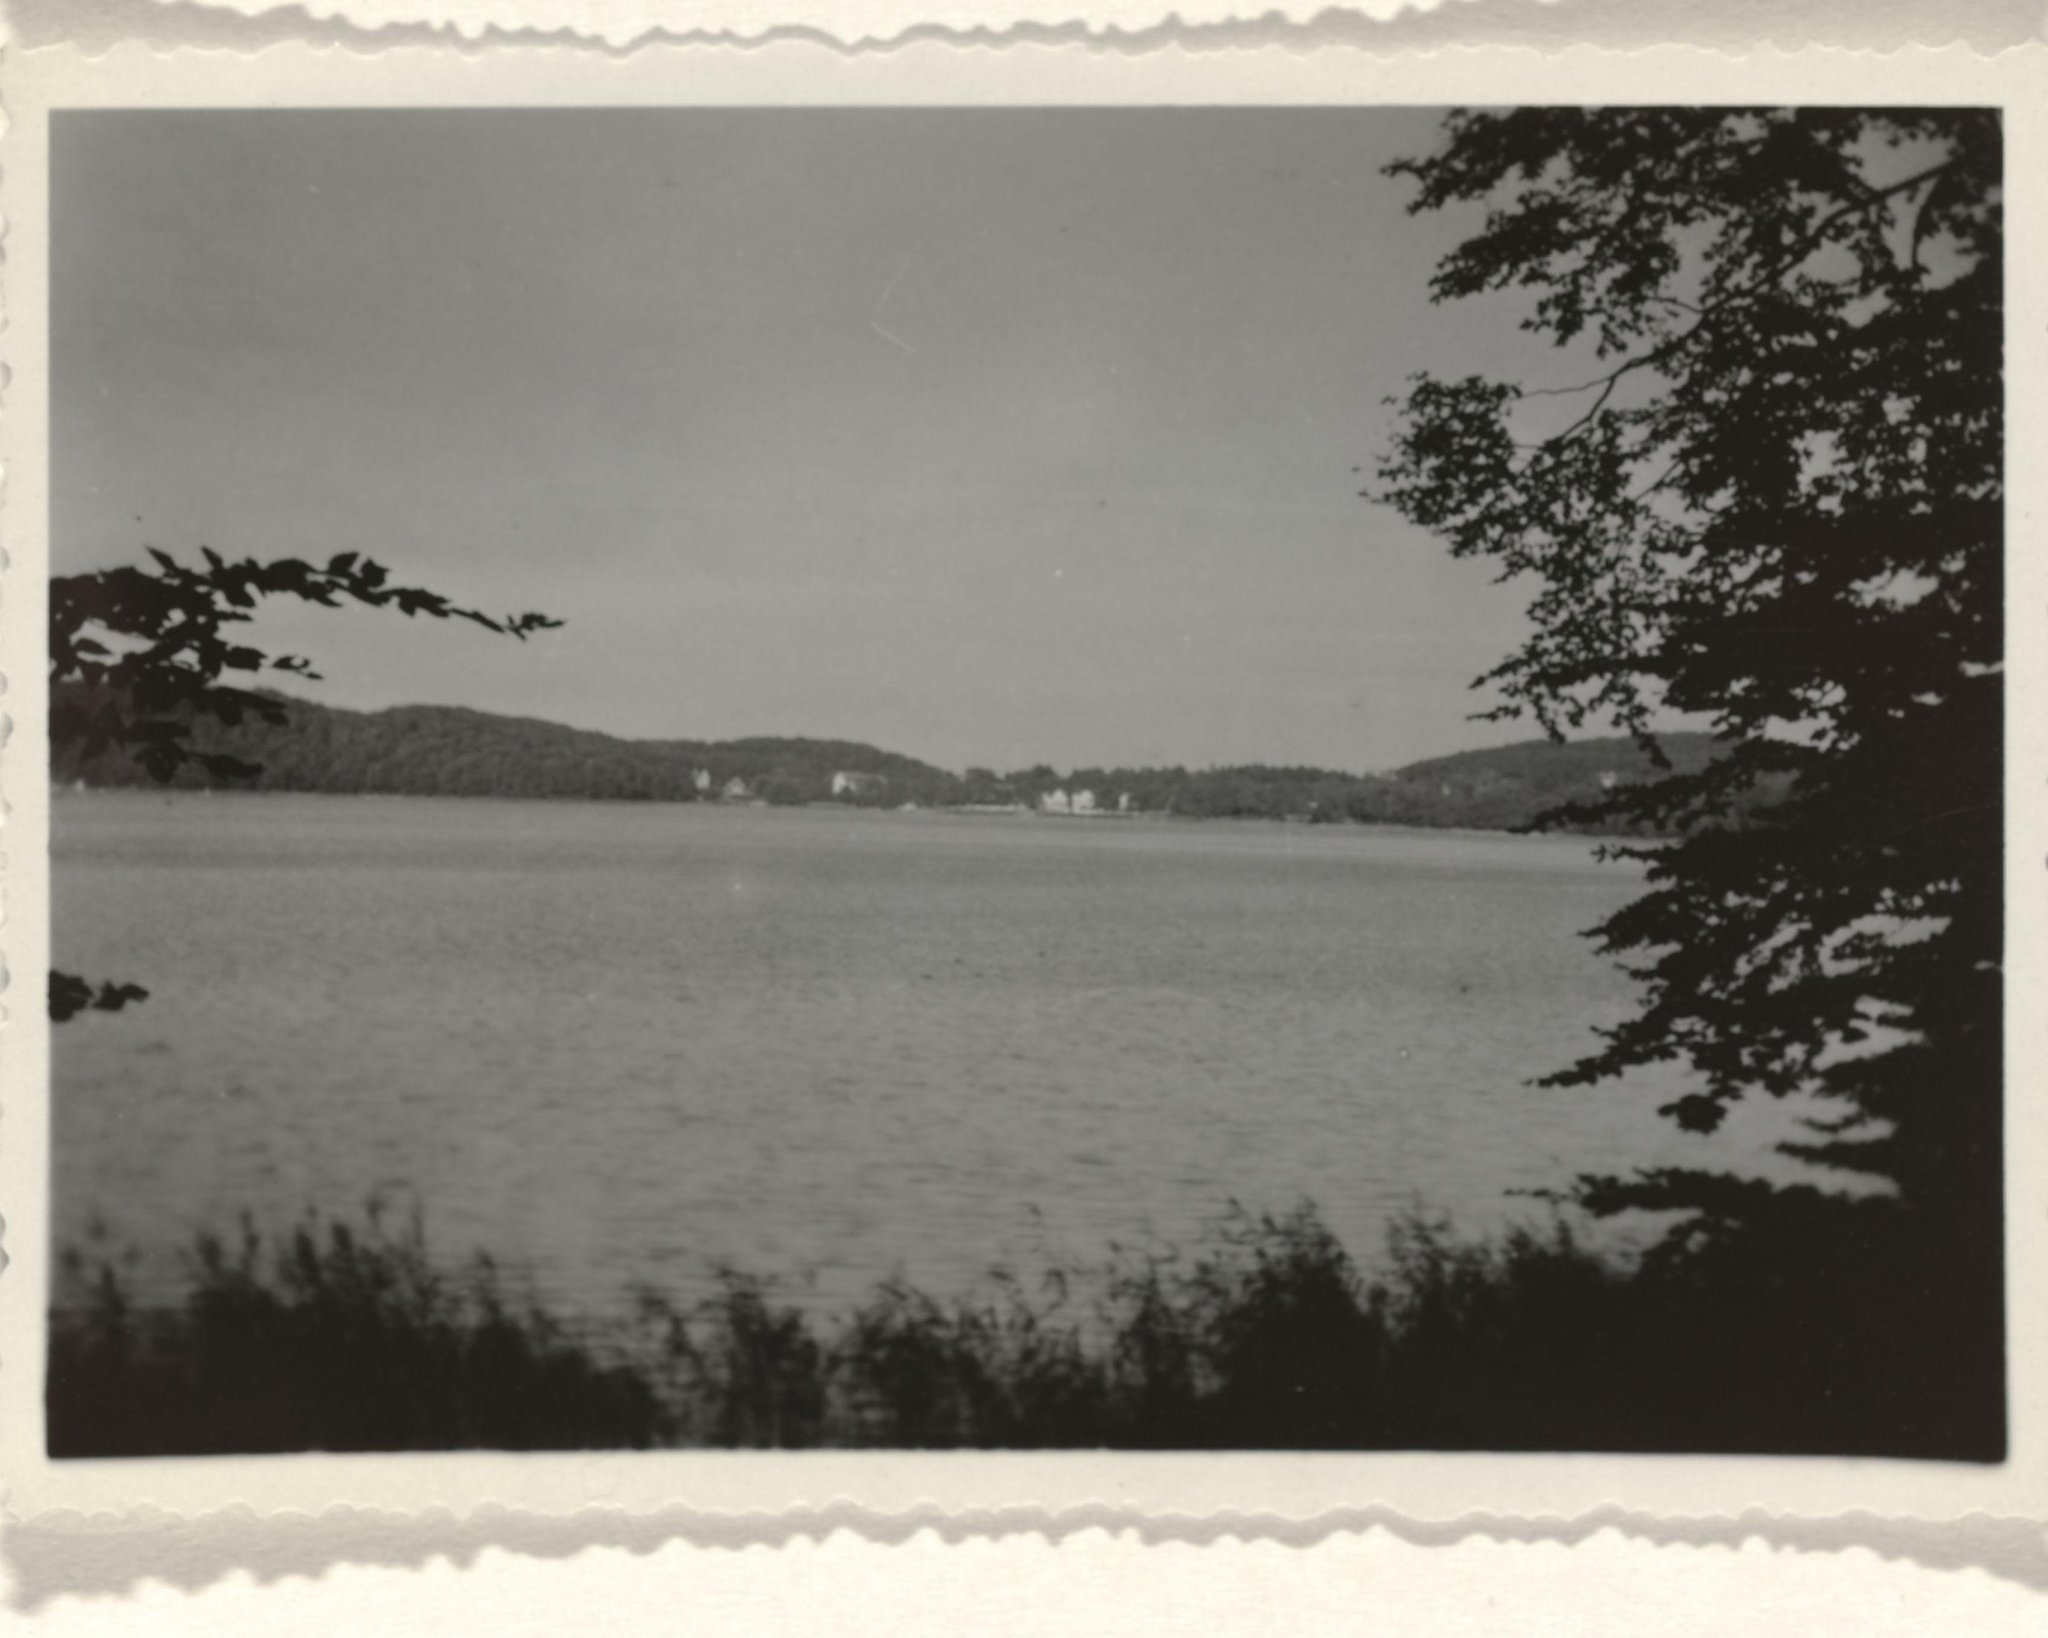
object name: photograph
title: Plänsee op de Zwitserse plaats Holstein, vanaf de oever van de Plänsee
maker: Anonymous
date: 1909-1934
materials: photographic support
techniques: gelatin silver print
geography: switzerland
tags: trübsee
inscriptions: inscription: ‘Sept 34. 12 Holstein, Schweiz Plänsee’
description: Zicht over de Plänsee op de Zwitserse plaats Holstein, vanaf de oever van de Plänsee.